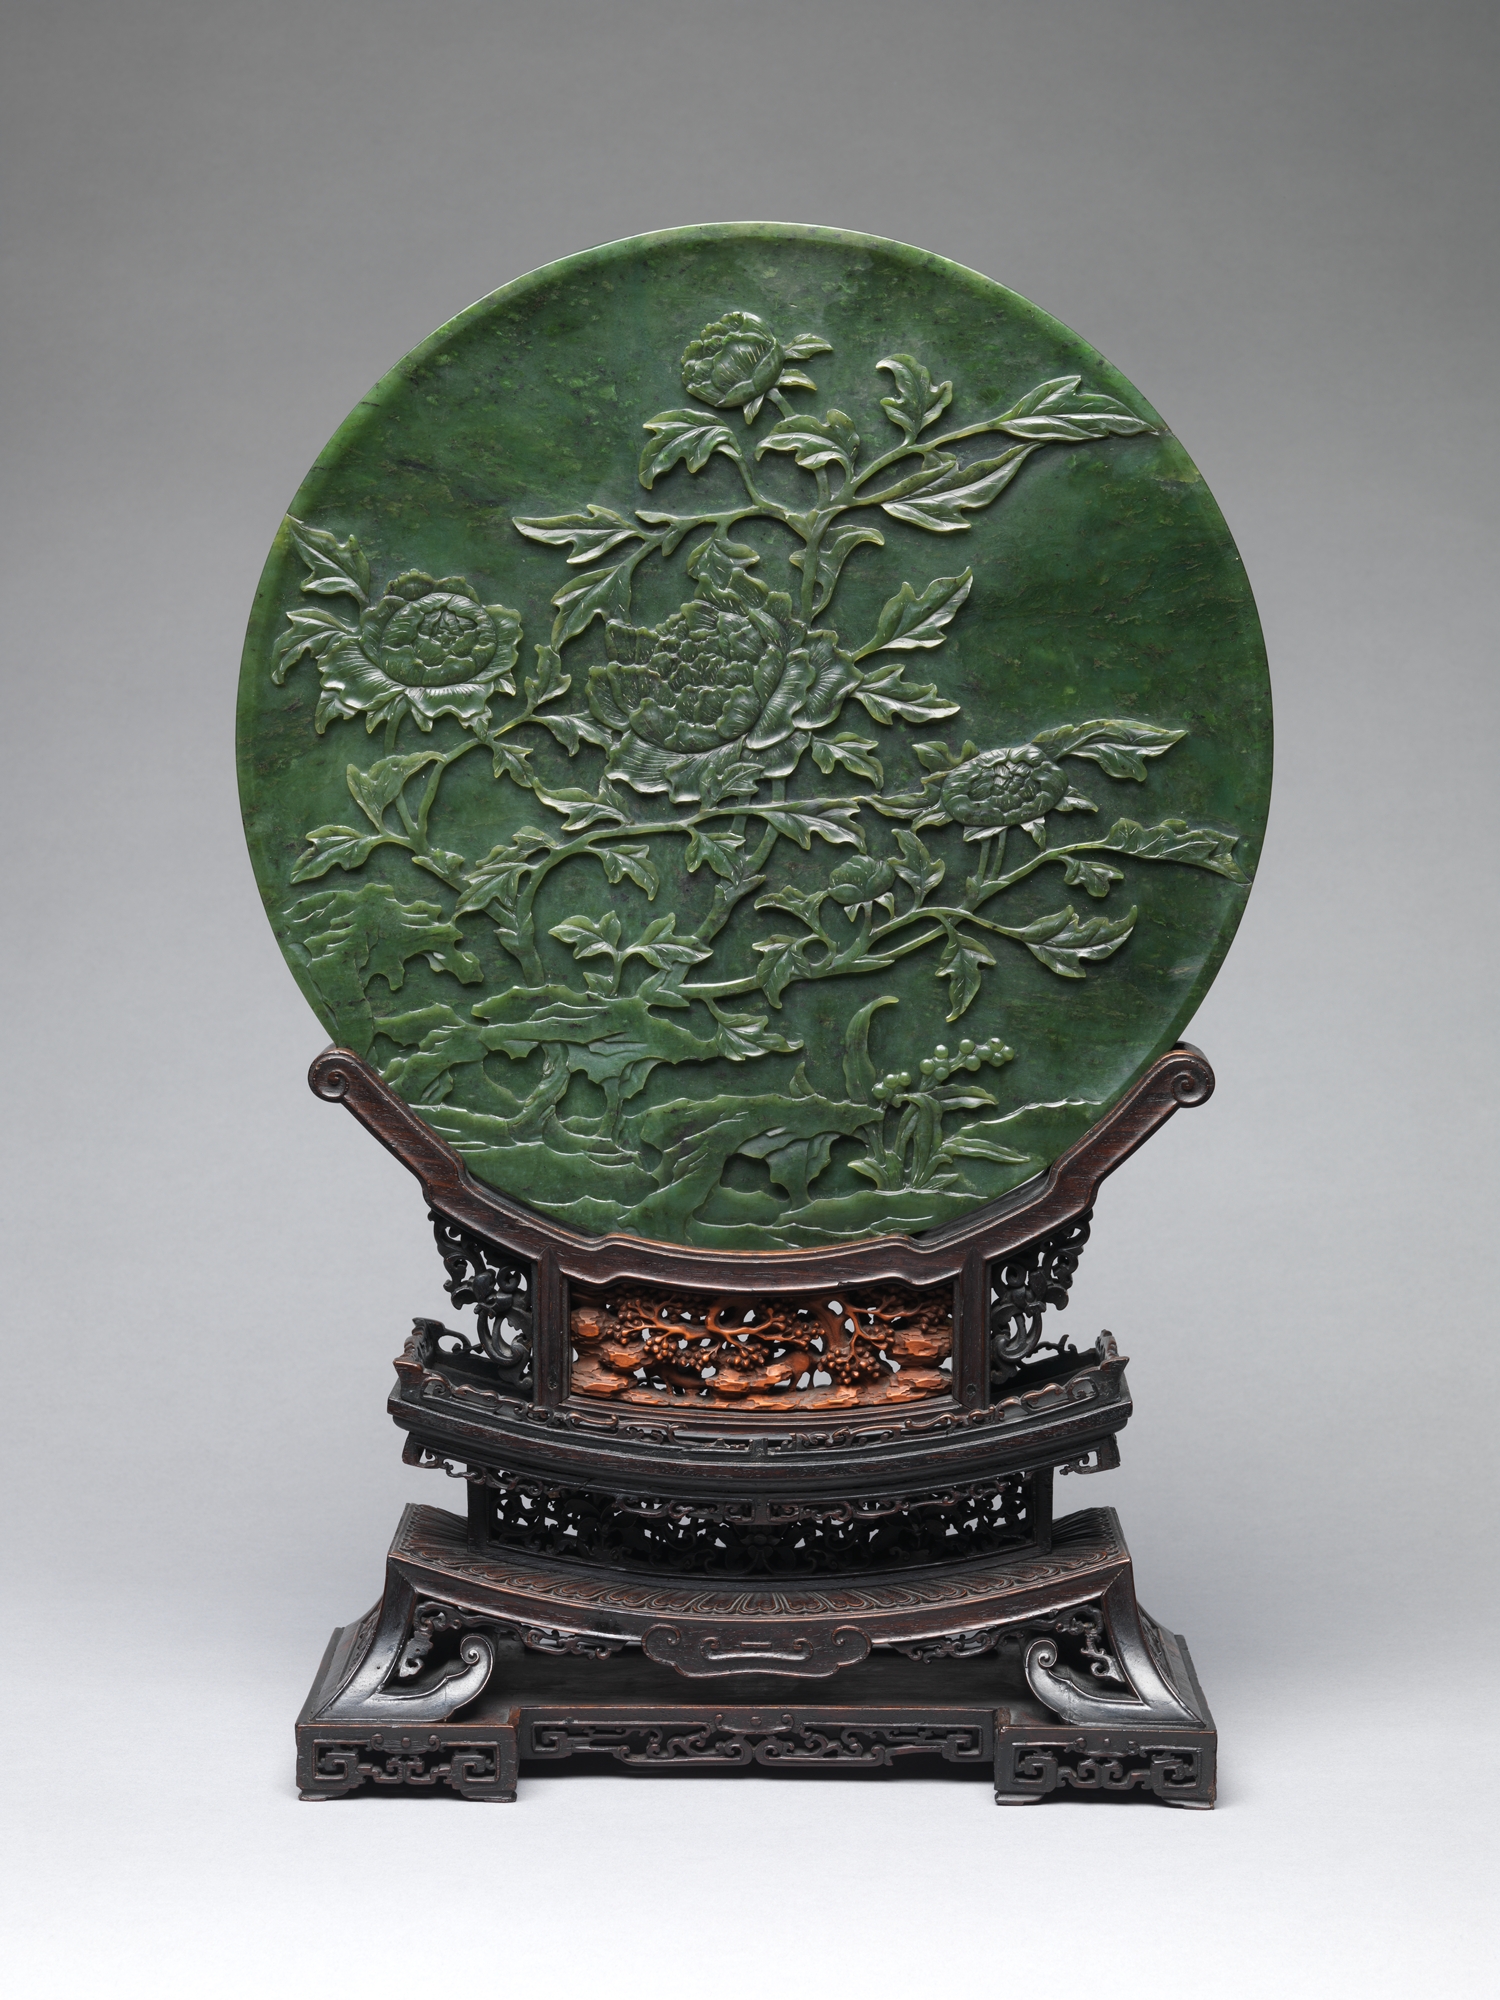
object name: table screen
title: Table Screen with Tree Peonies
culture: chinese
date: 1701-1800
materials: jade, wood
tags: peonies